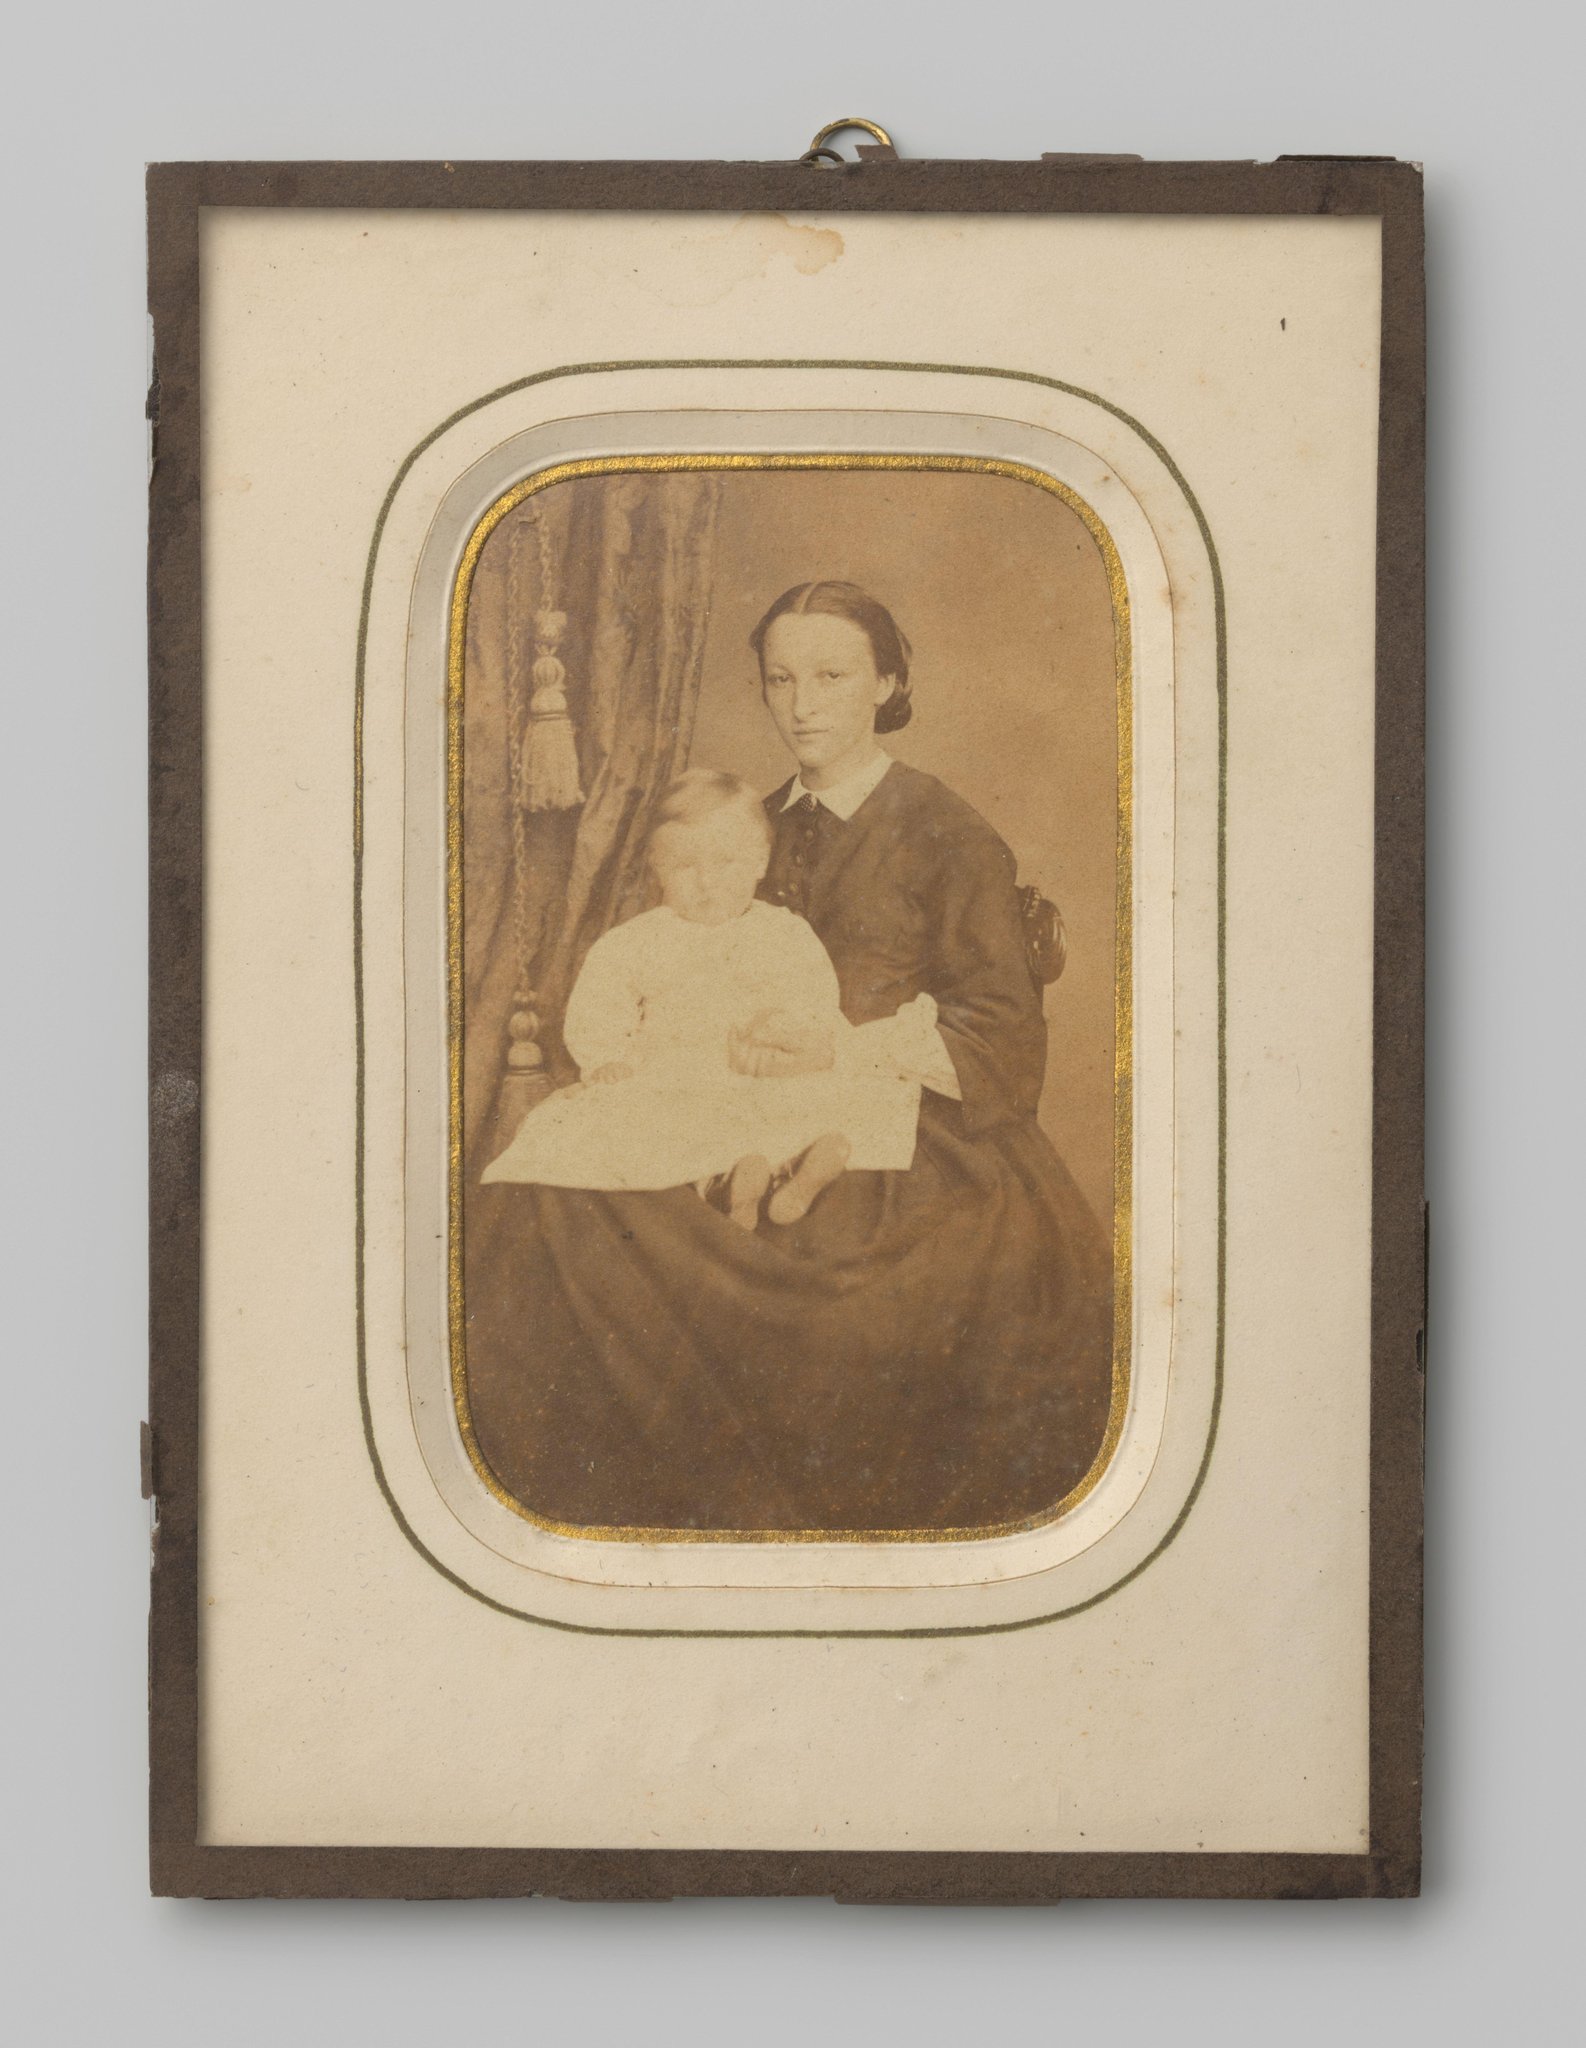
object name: frame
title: Portret van een onbekende moeder met kind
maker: Anonymous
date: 1880-1900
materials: cardboard, glass, paper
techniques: albumen print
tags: adult woman, anonymous historical person portrayed